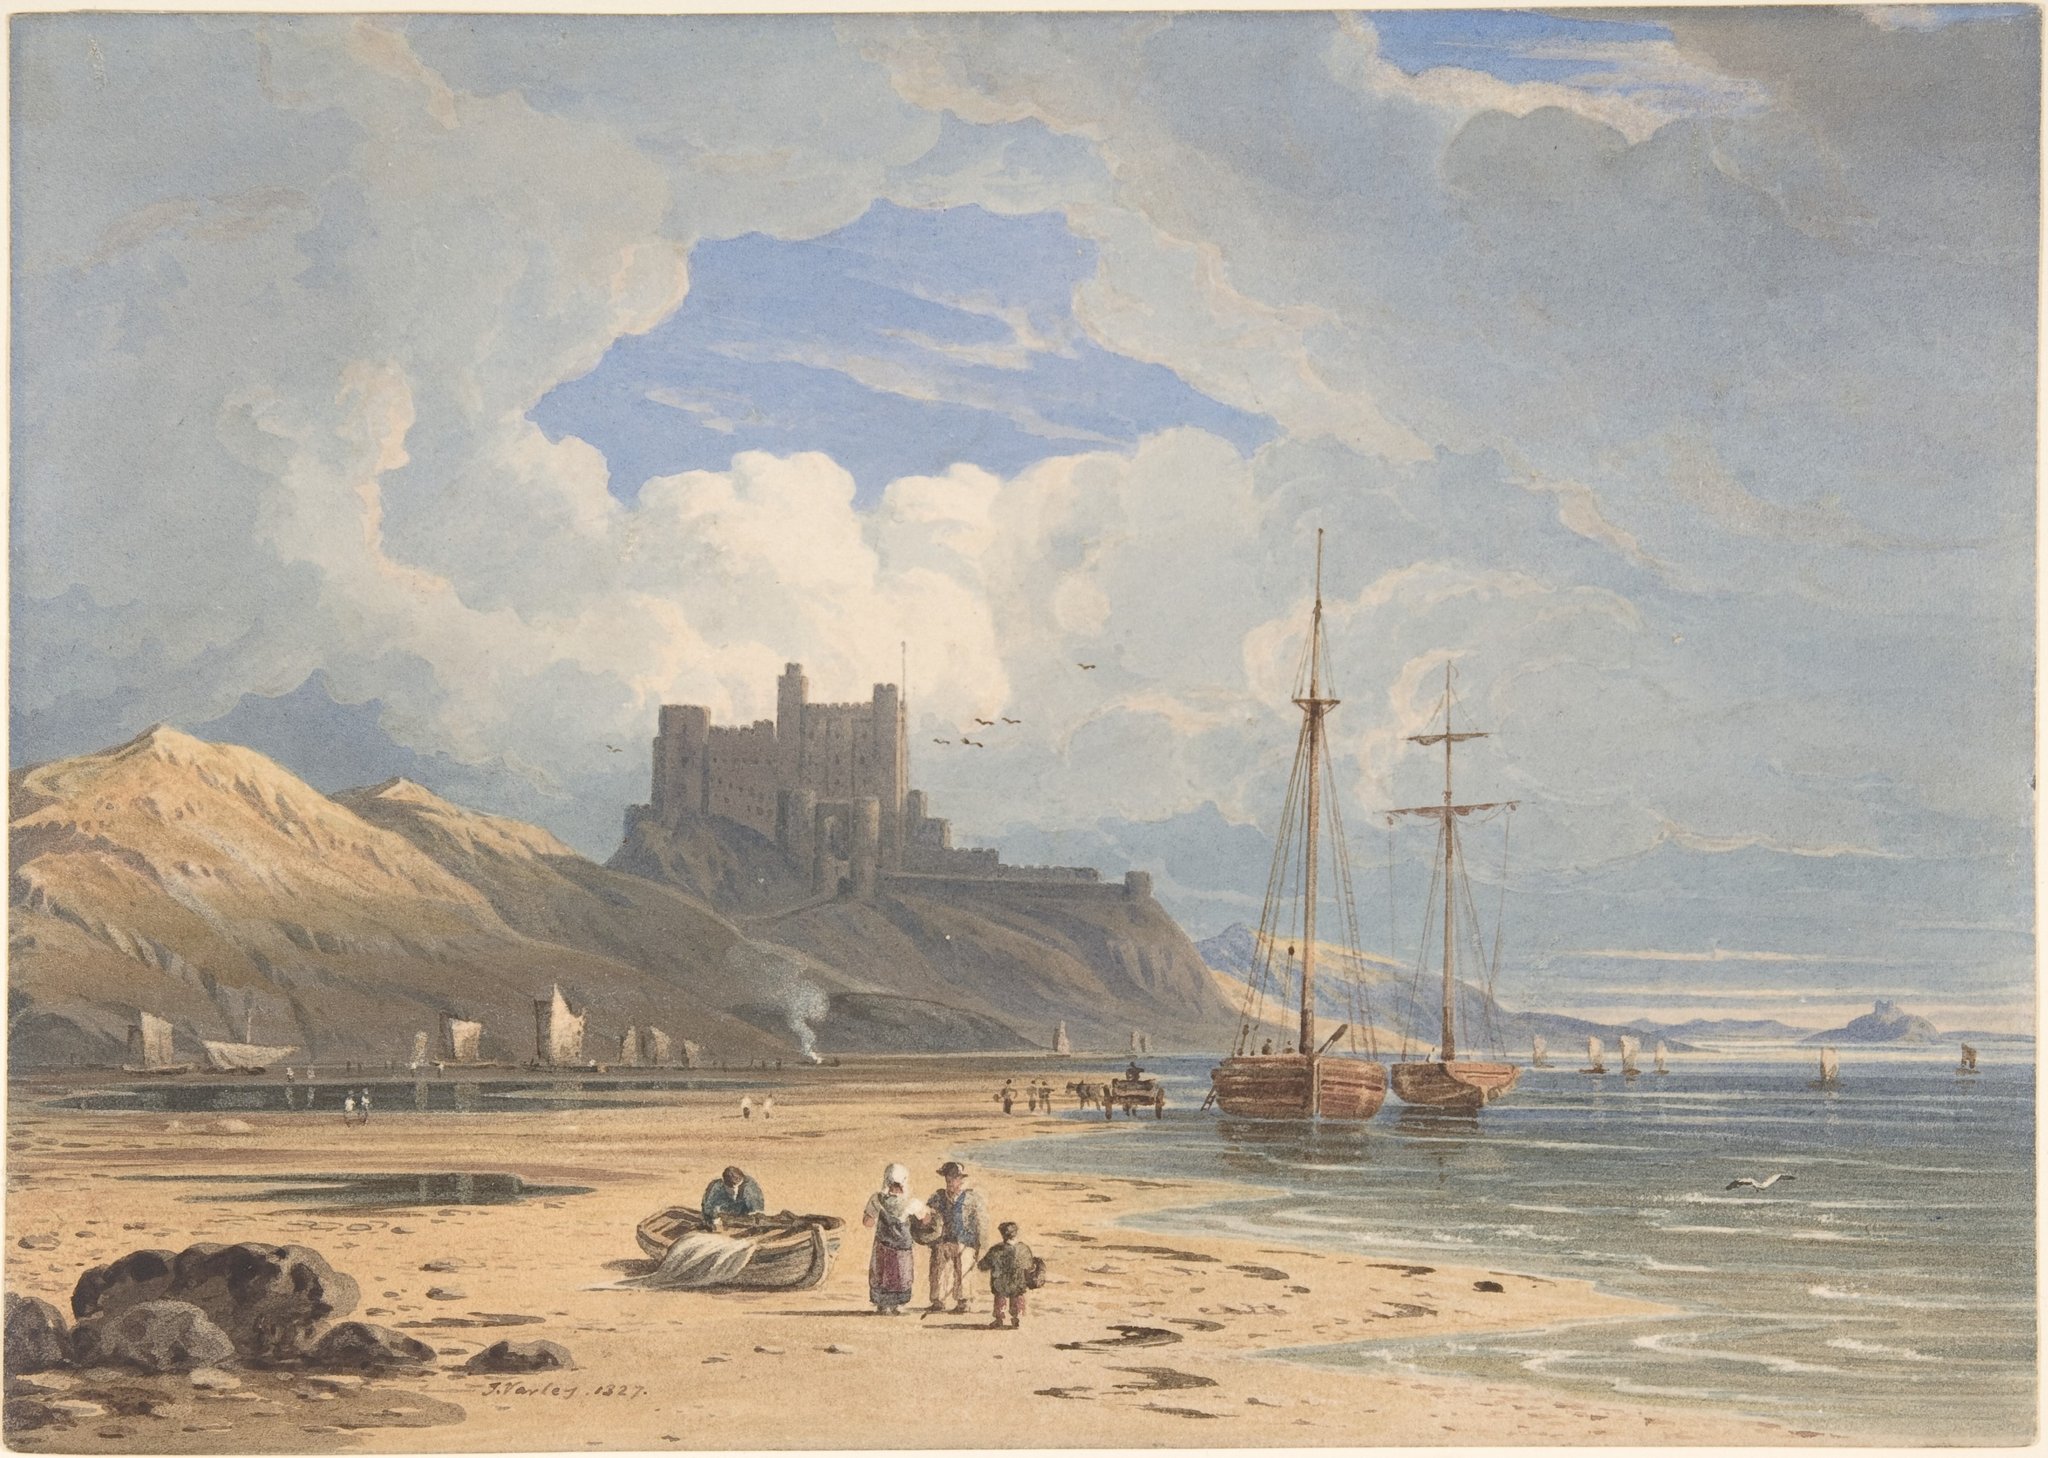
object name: drawing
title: Bamborough Castle from the Northeast, with Holy Island in the Distance, Northumberland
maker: john varley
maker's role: artist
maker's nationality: british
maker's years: 1778-1842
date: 1827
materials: graphite, watercolor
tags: castles,beaches,ships